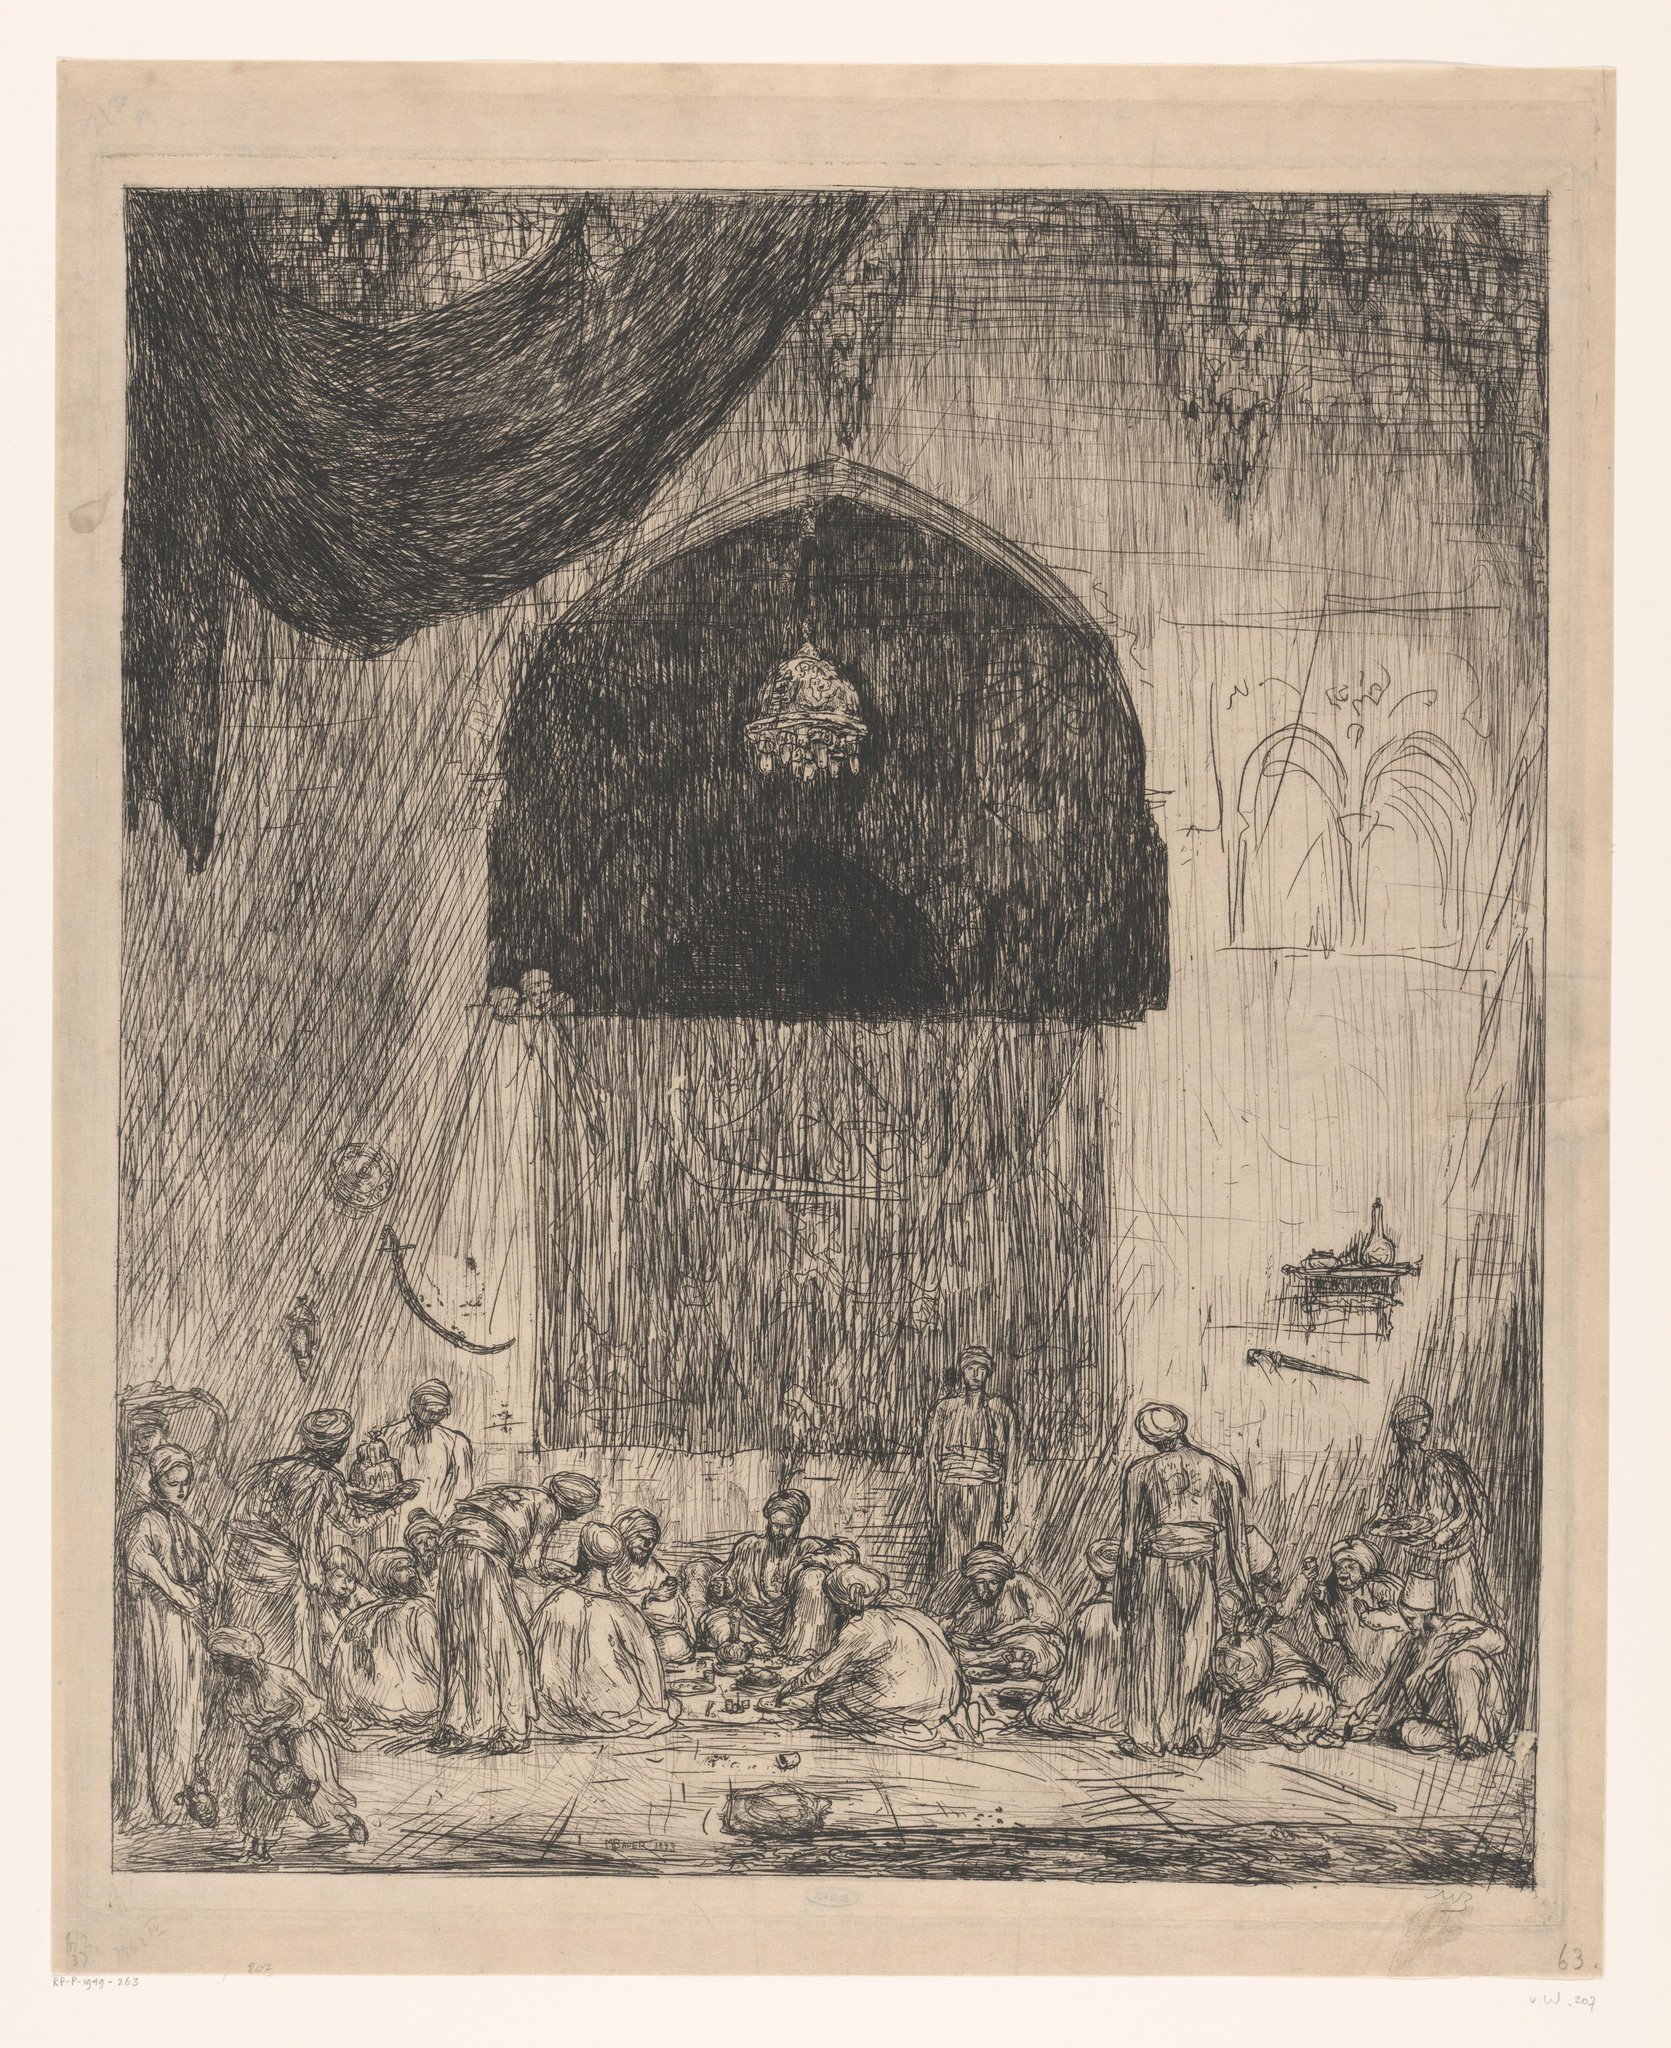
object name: print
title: Etende, oosterse mannen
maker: marius bauer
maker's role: draughtsman, print maker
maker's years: 1867-1932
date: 1893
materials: paper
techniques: etching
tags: head-gear, eating, house personnel, servants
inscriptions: collector's mark: Lugt 2228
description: Om de groep zittende mannen op de grond staan bediendes.